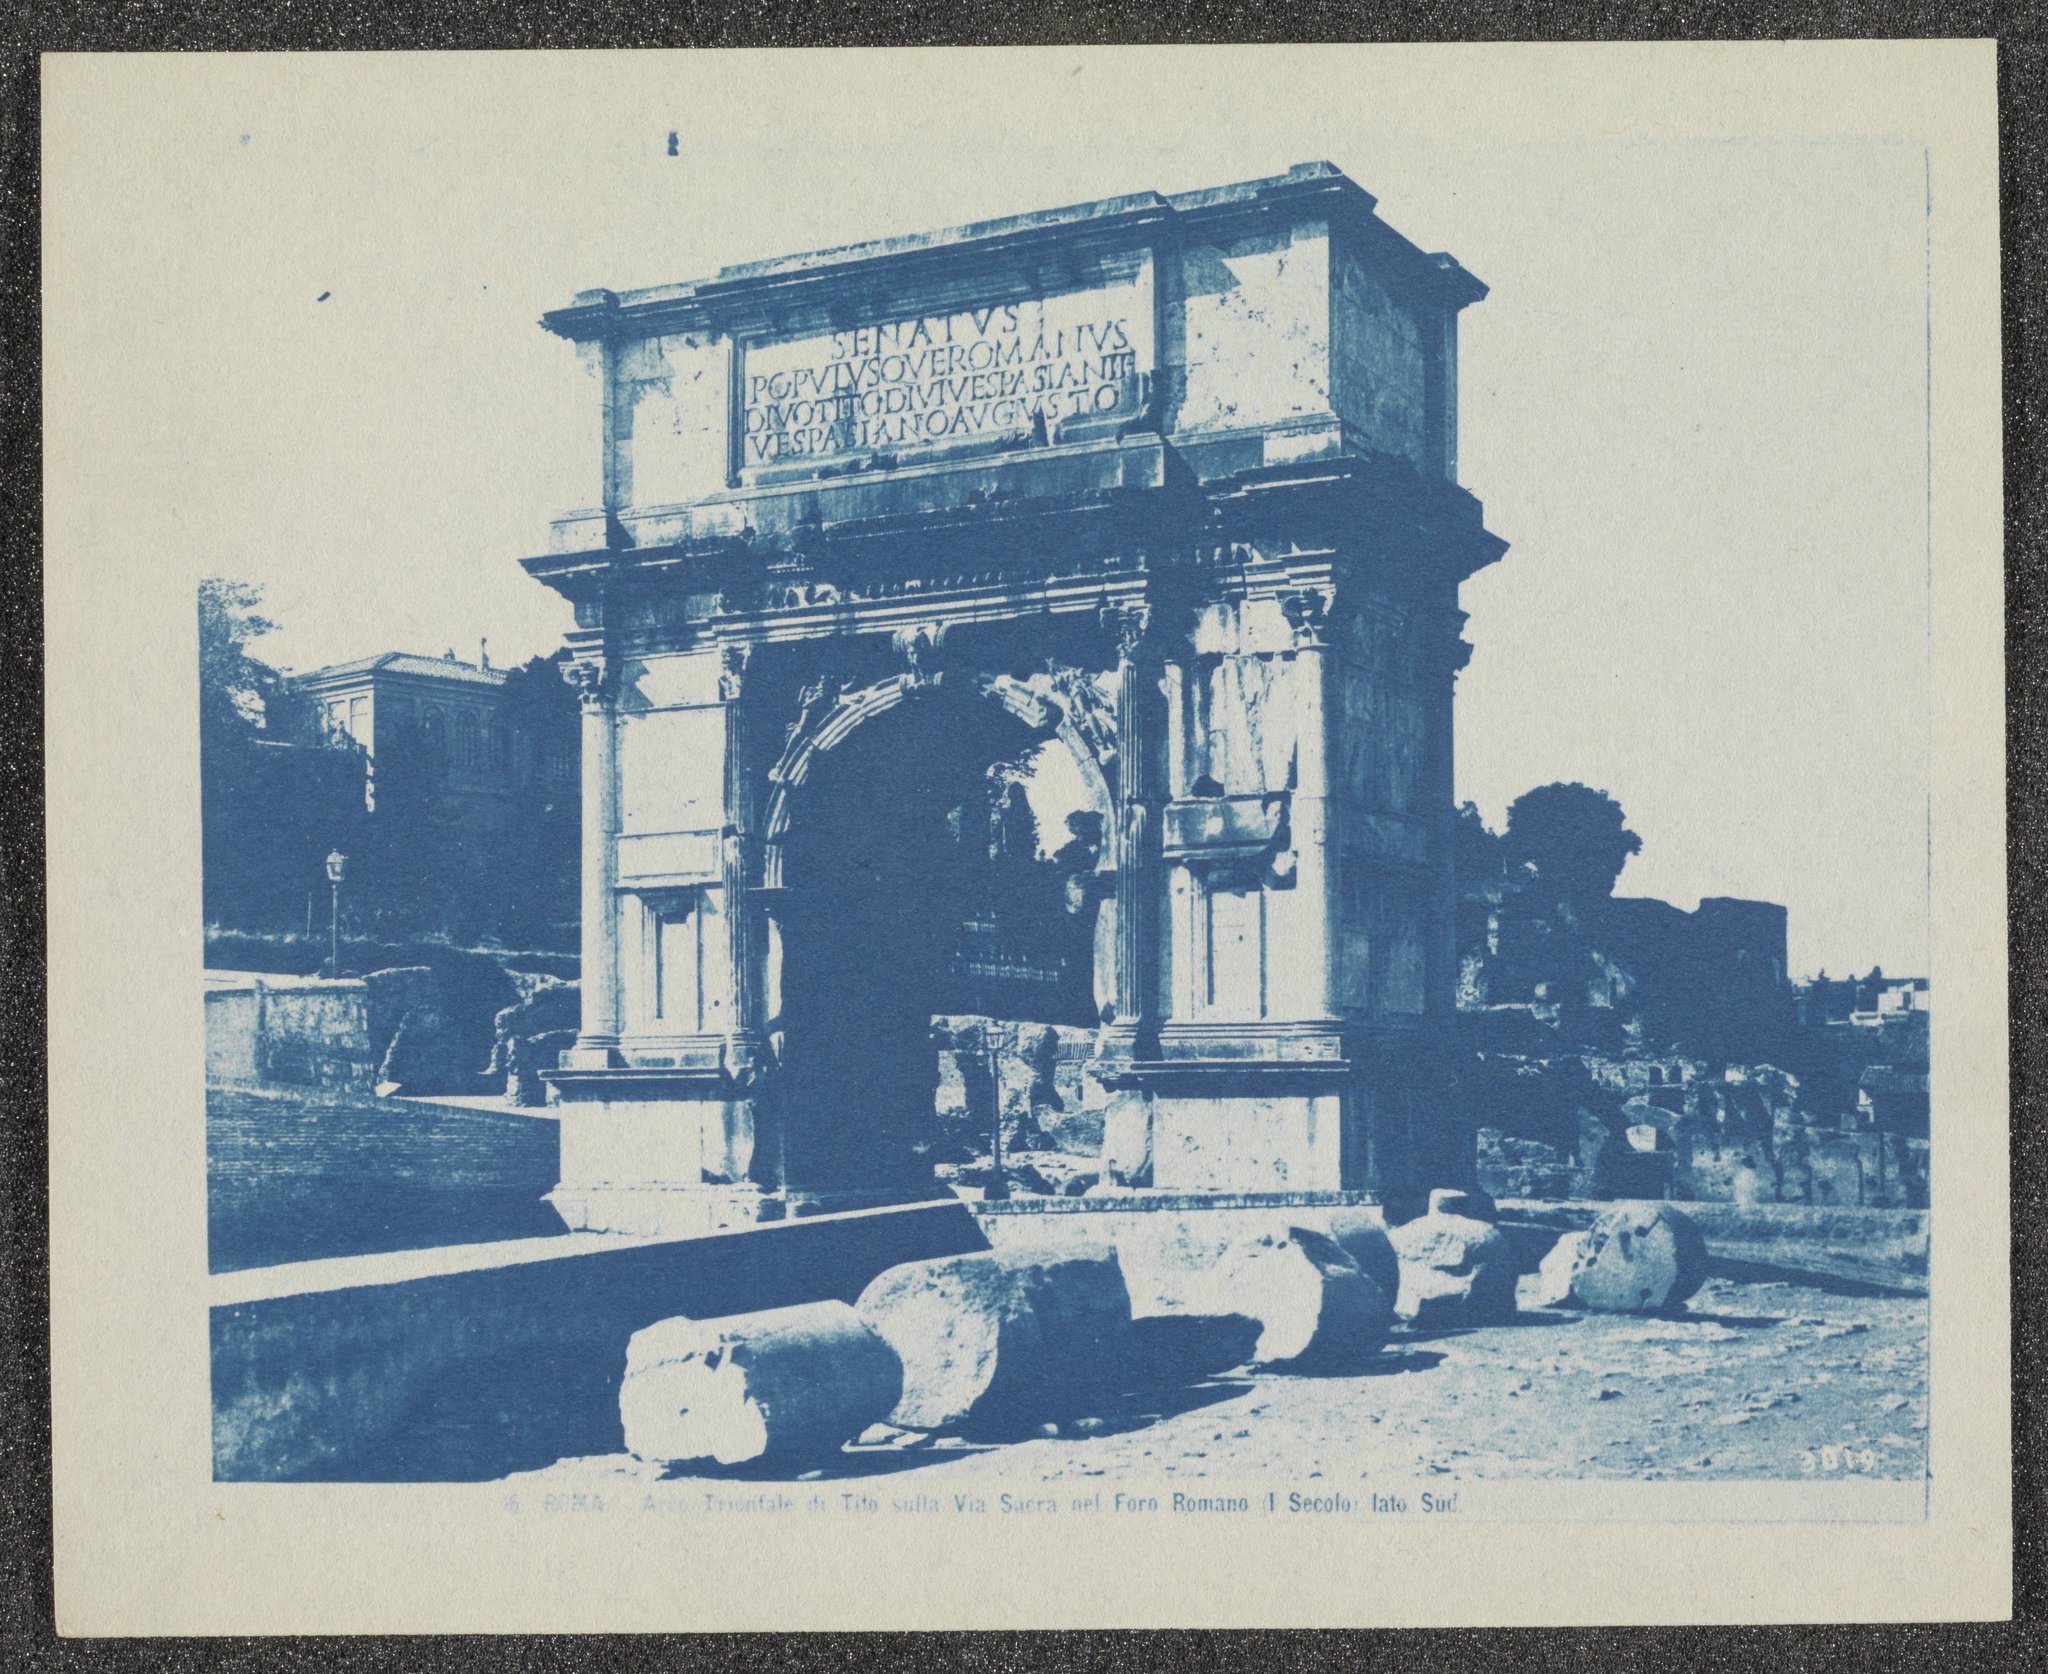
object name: photograph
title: Fotoreproductie van een foto van de Boog van Titus te Rome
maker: Anonymous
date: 1880-1905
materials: paper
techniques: cyanotype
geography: rome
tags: triumphal arch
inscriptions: number: ‘3019’, inscription: ‘Arch of Titus [...]’